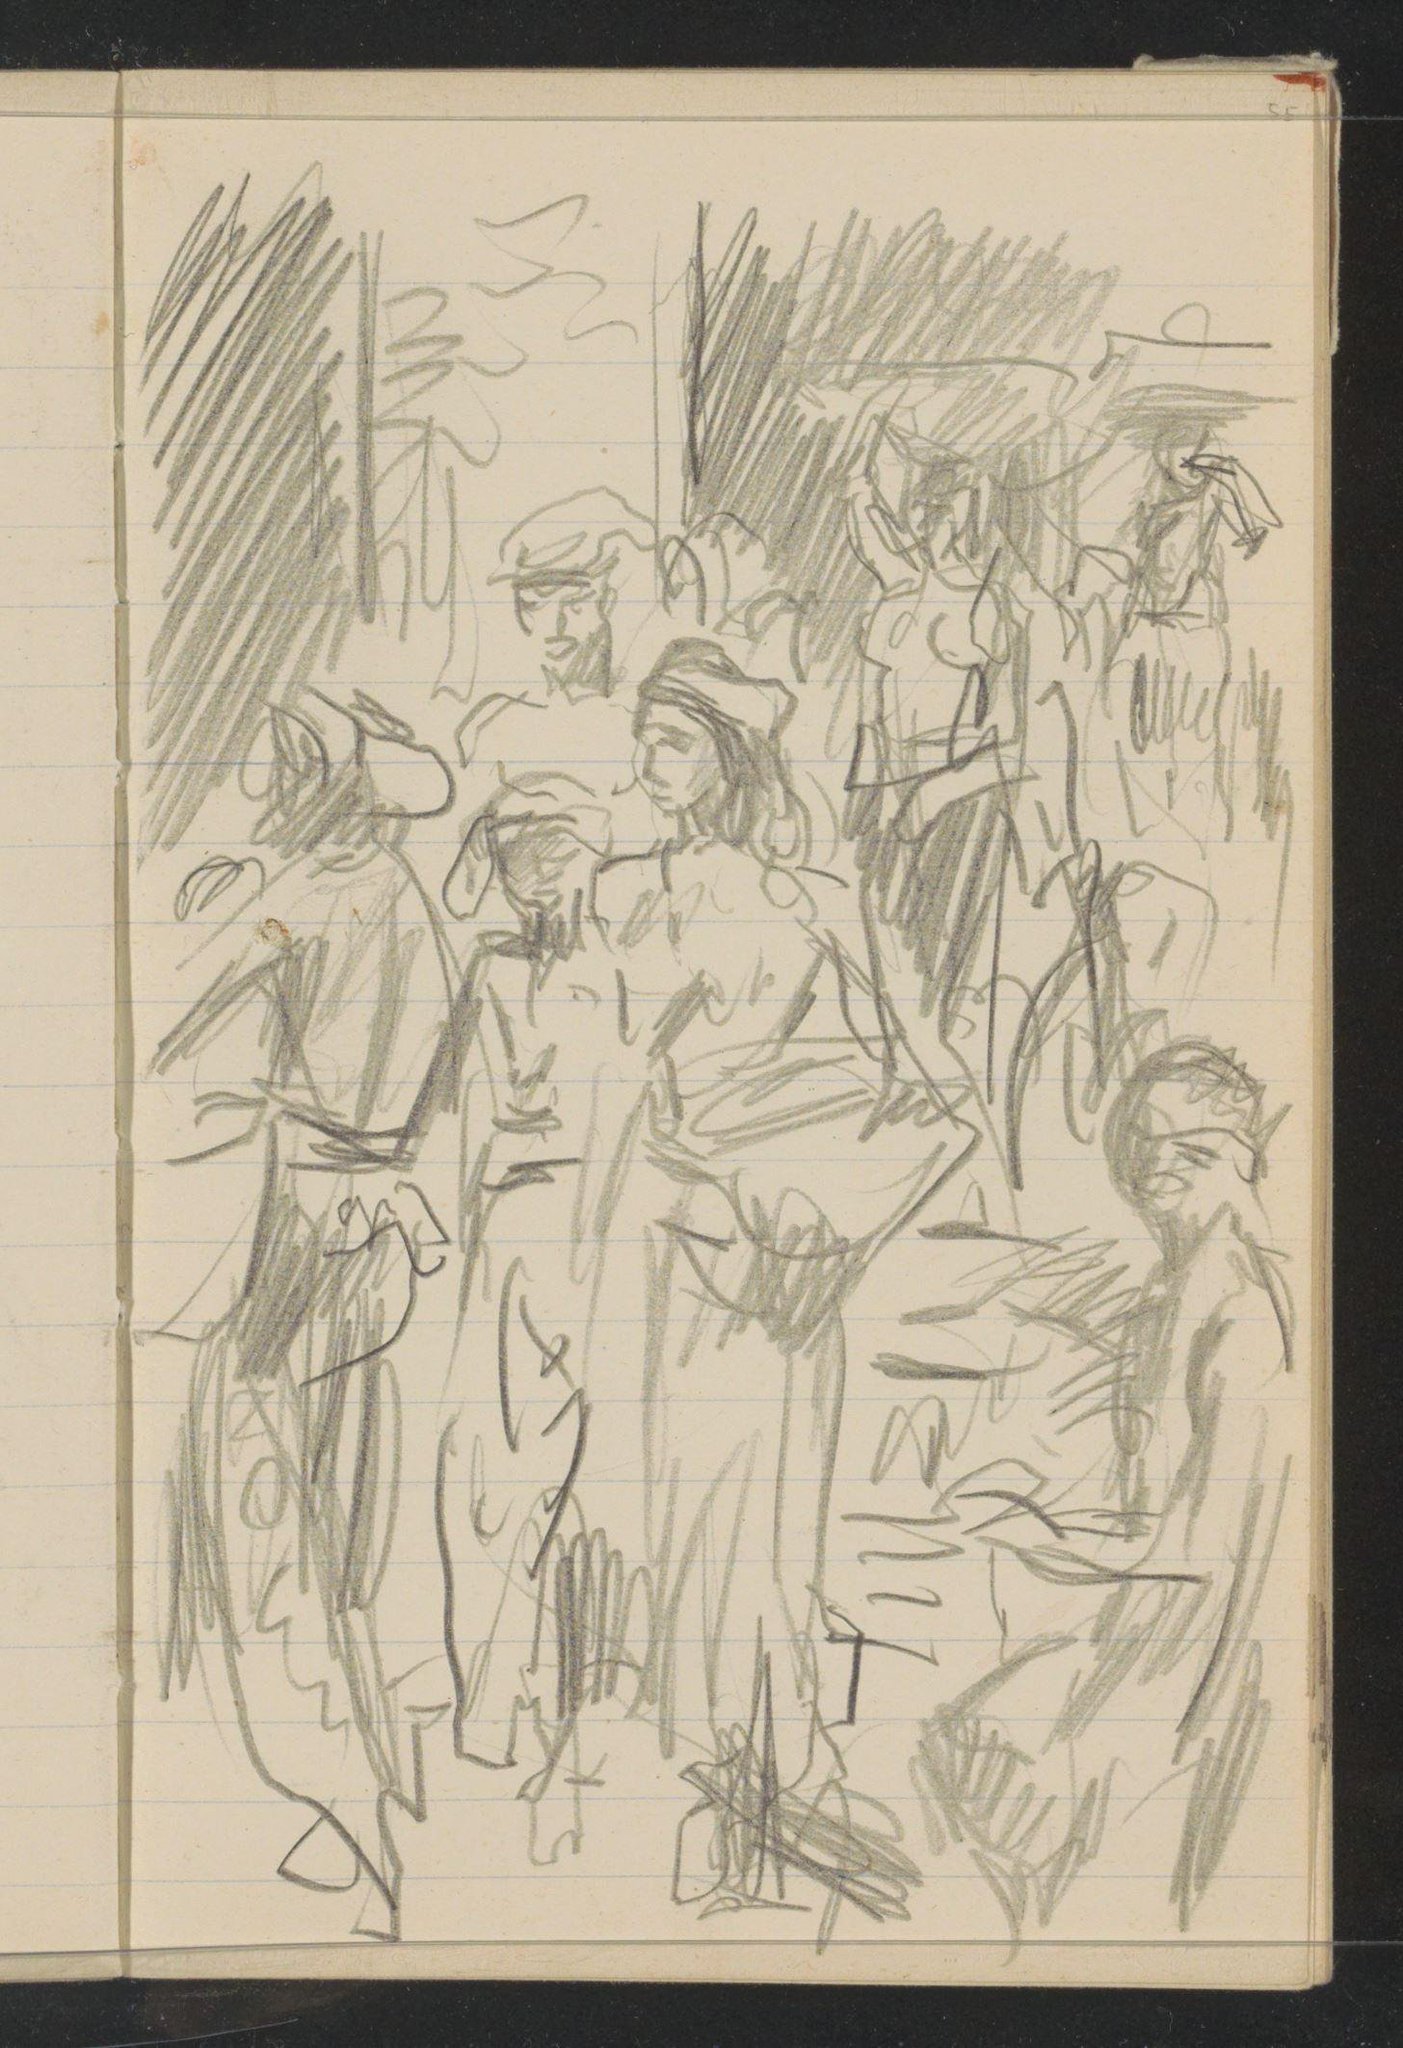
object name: sketchbook leaf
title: Straat met figuren met schalen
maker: marius bauer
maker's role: draughtsman, print maker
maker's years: 1867-1932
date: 1931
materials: pencil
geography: bali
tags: bowl, carrying something on the head or on the shoulders, street (+ city(-scape) with figures, staffage)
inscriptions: kleurnotitie, handgeschreven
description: Mogelijk bevatten de schalen offers voor een offerfeest. Pagina 55 uit een schetsboek met 74 bladen.